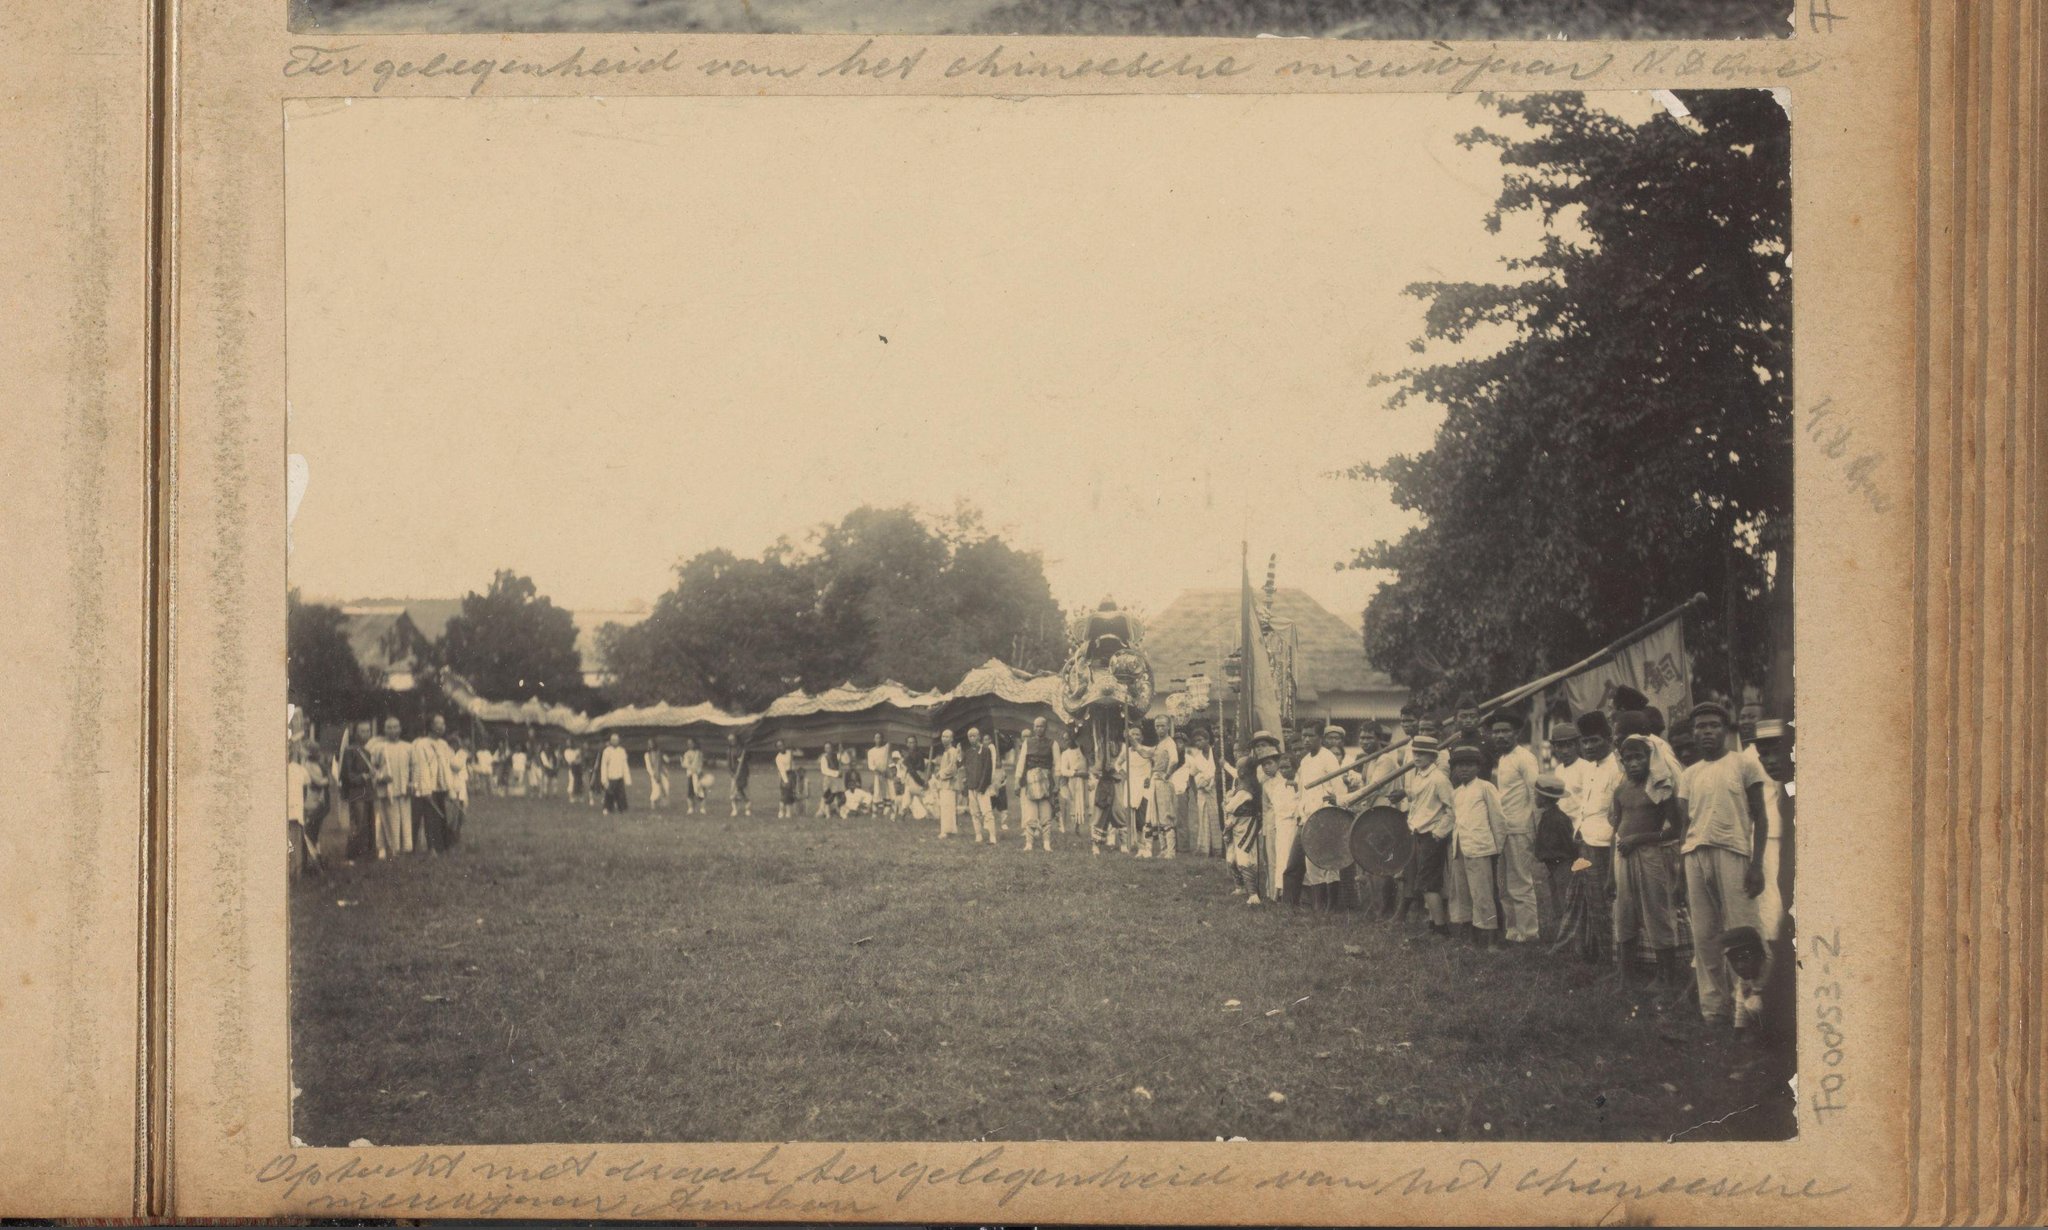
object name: album leaf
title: Optocht met een draak en vaandels tijdens Chinees Nieuwjaar op Ambon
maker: Anonymous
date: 1900-1920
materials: cardboard, paper, photographic support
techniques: daylight paper print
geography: ambon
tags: public festivities, dragon, dutch east indies, the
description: Onderdeel van Reisalbum met foto's van Ambon.